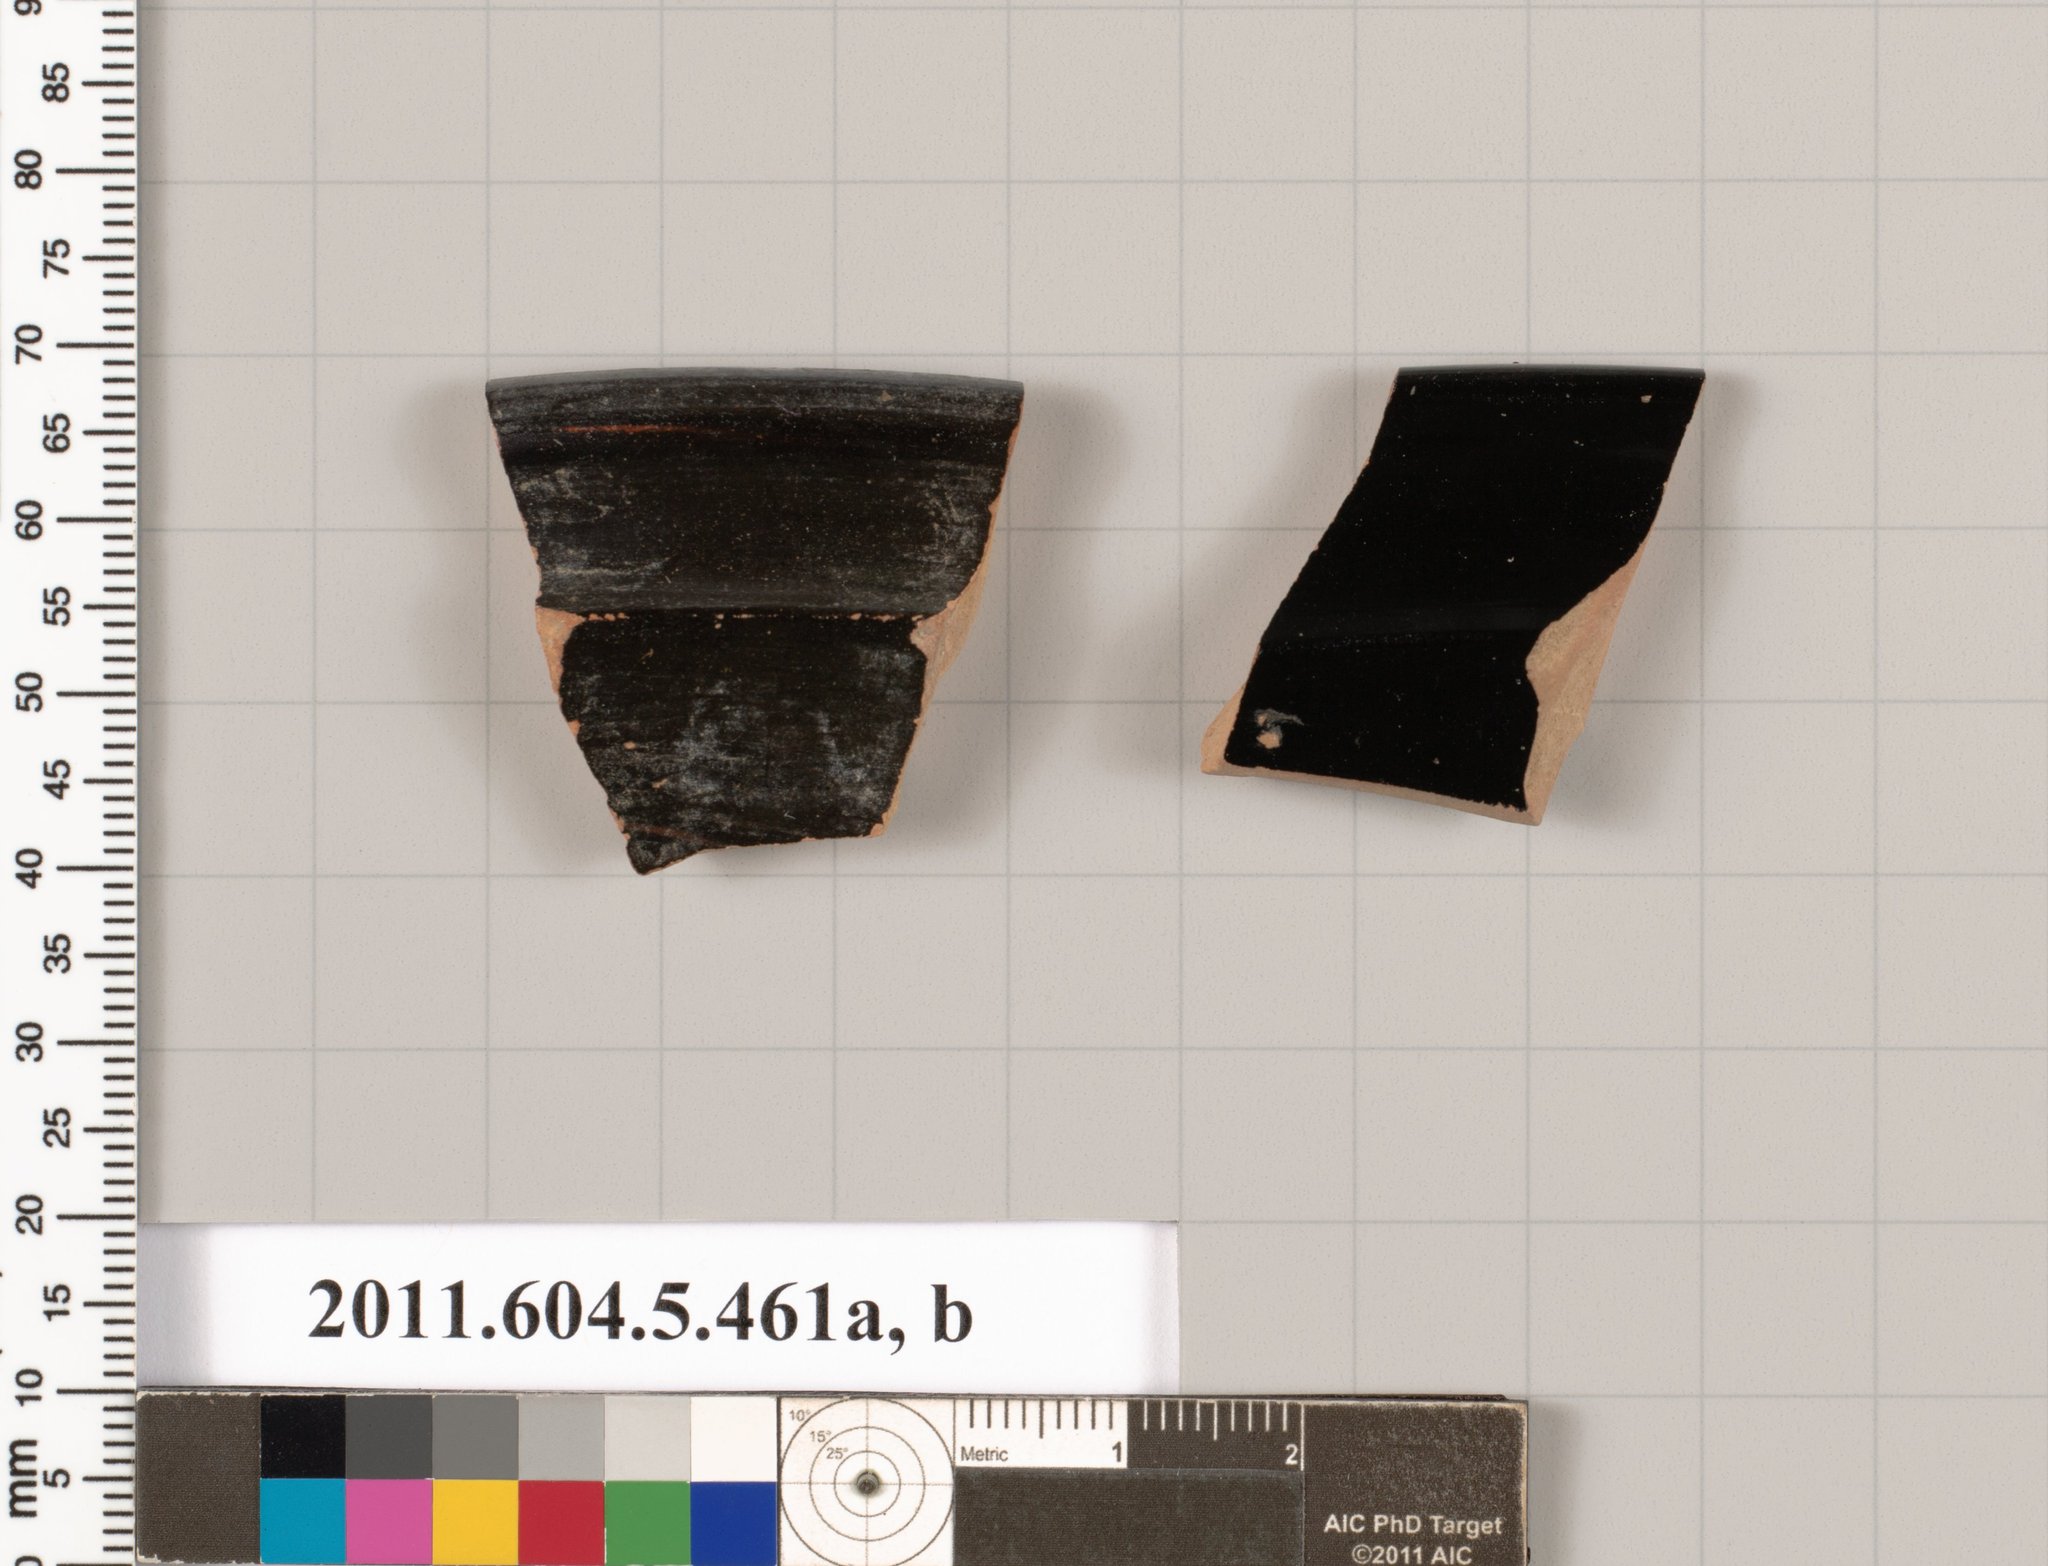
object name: kylix fragment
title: Terracotta rim fragments of kylikes (drinking cups)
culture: greek, attic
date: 600-401 BCE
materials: terracotta